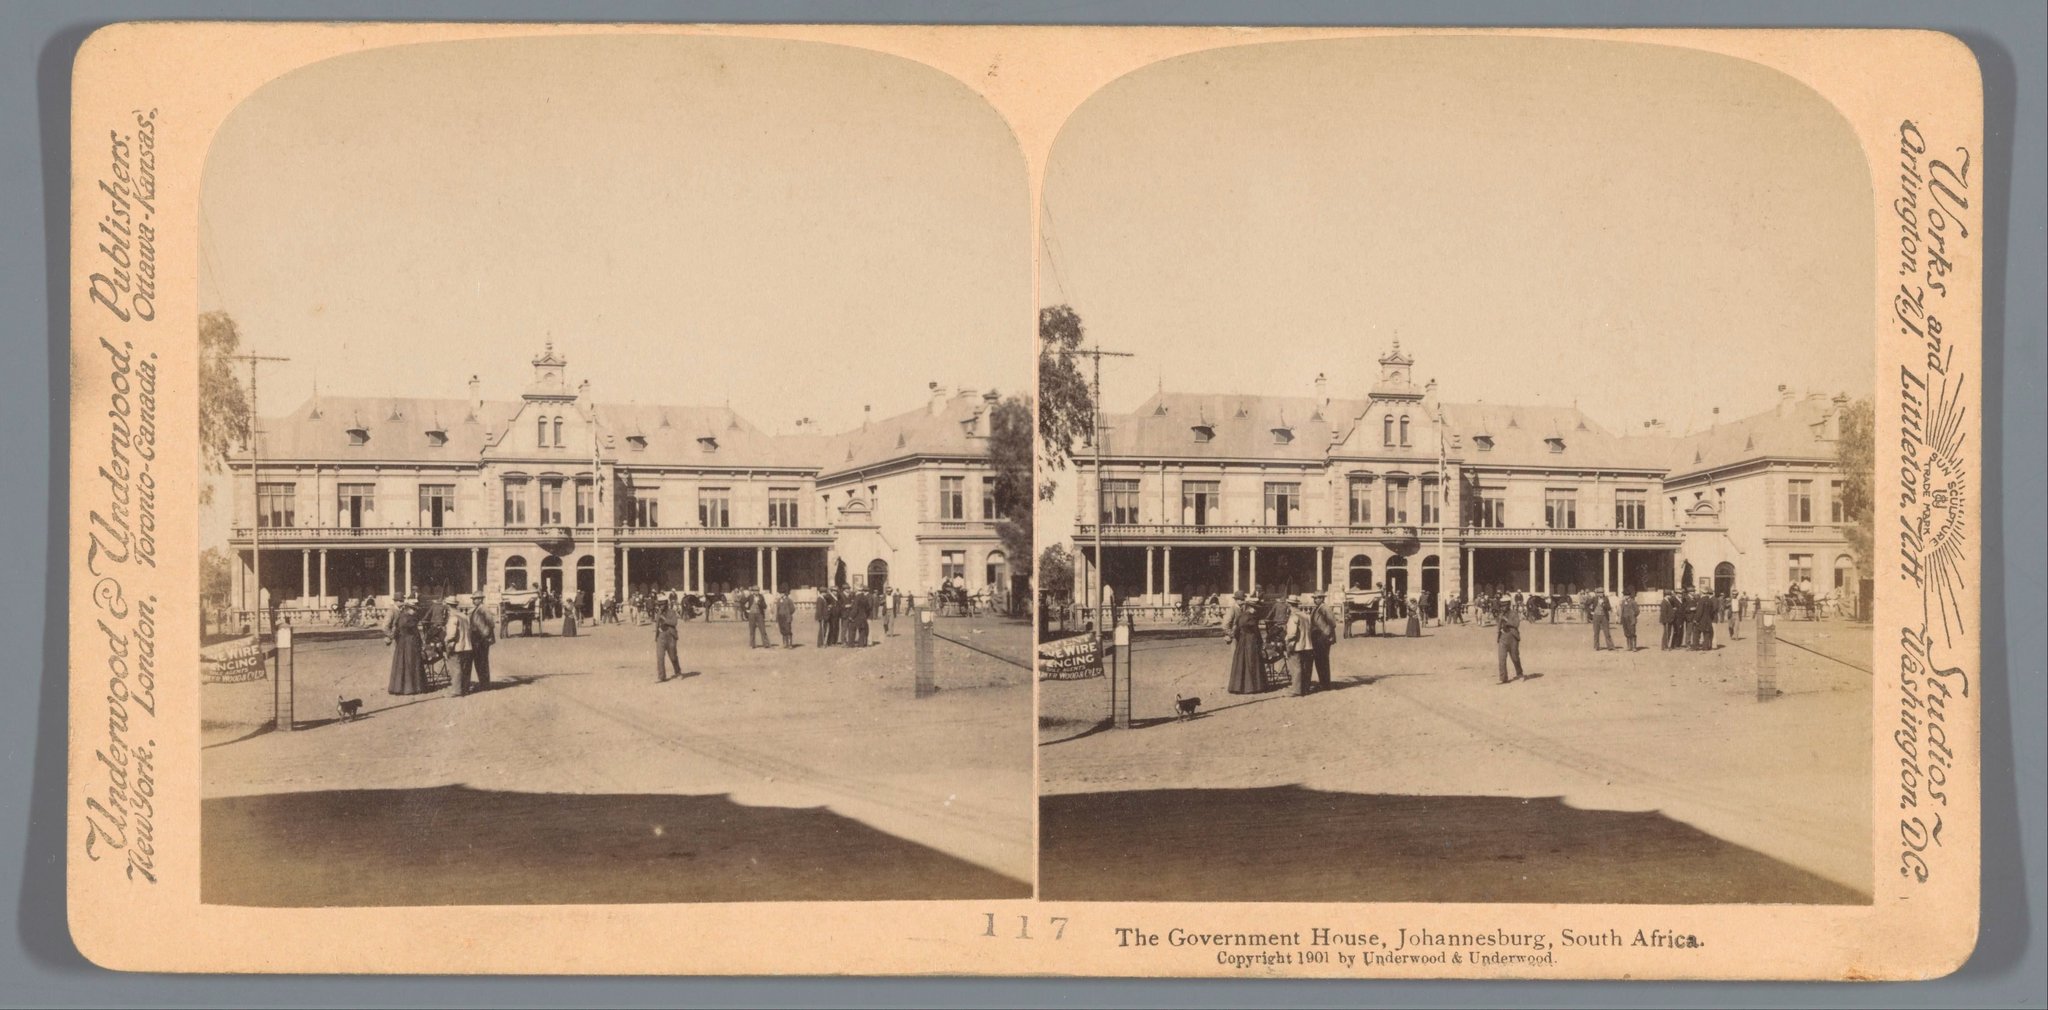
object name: stereograph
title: The Government House, Johannesburg, South Africa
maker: Anonymous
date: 1901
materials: cardboard, paper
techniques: albumen print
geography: new york city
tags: government services, public services, façade (of house or building), johannesburg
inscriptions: inscription, copyright notice: ‘Copyright 1901 by Underwood & Underwood.’, number: ‘117’, inscription: ‘Works and Studios ~/ Arlington, N.J. Littleton, N.H. Washington, D.C.’